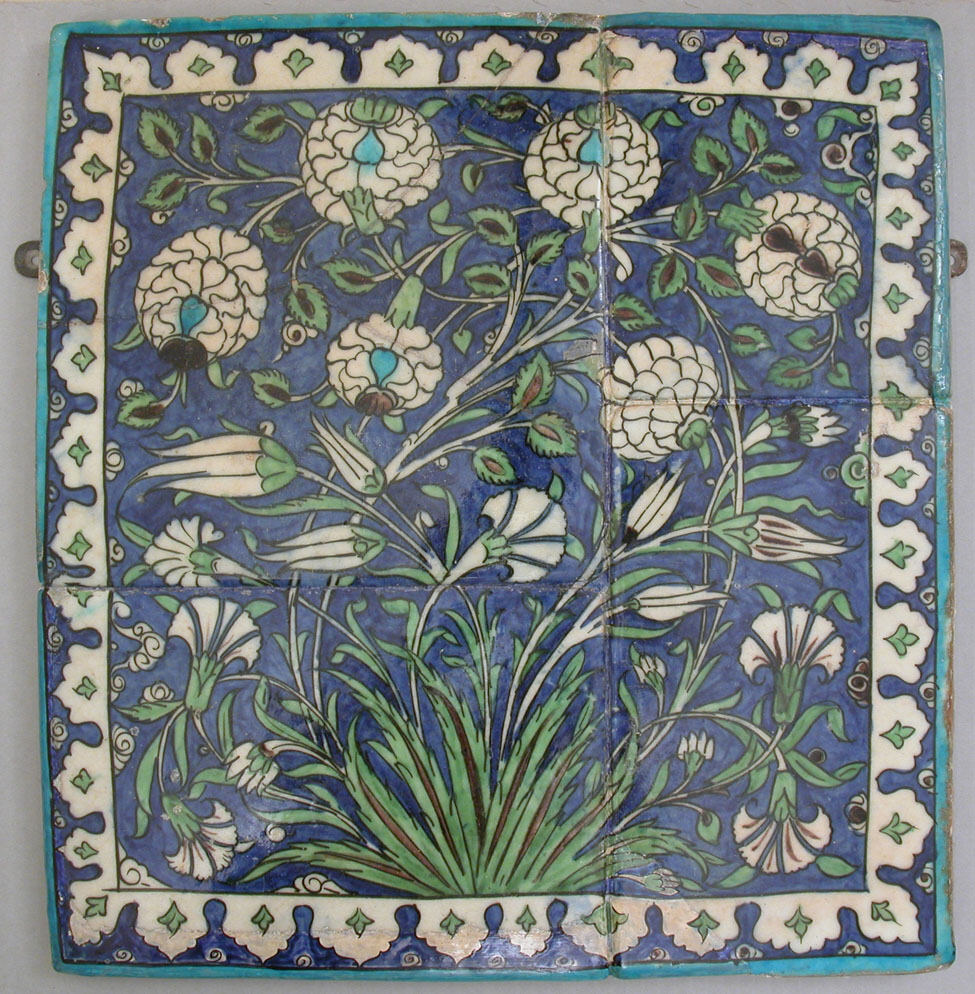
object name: tile panel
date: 1551-1600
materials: stonepaste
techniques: painting, underglaze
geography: syria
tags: flowers